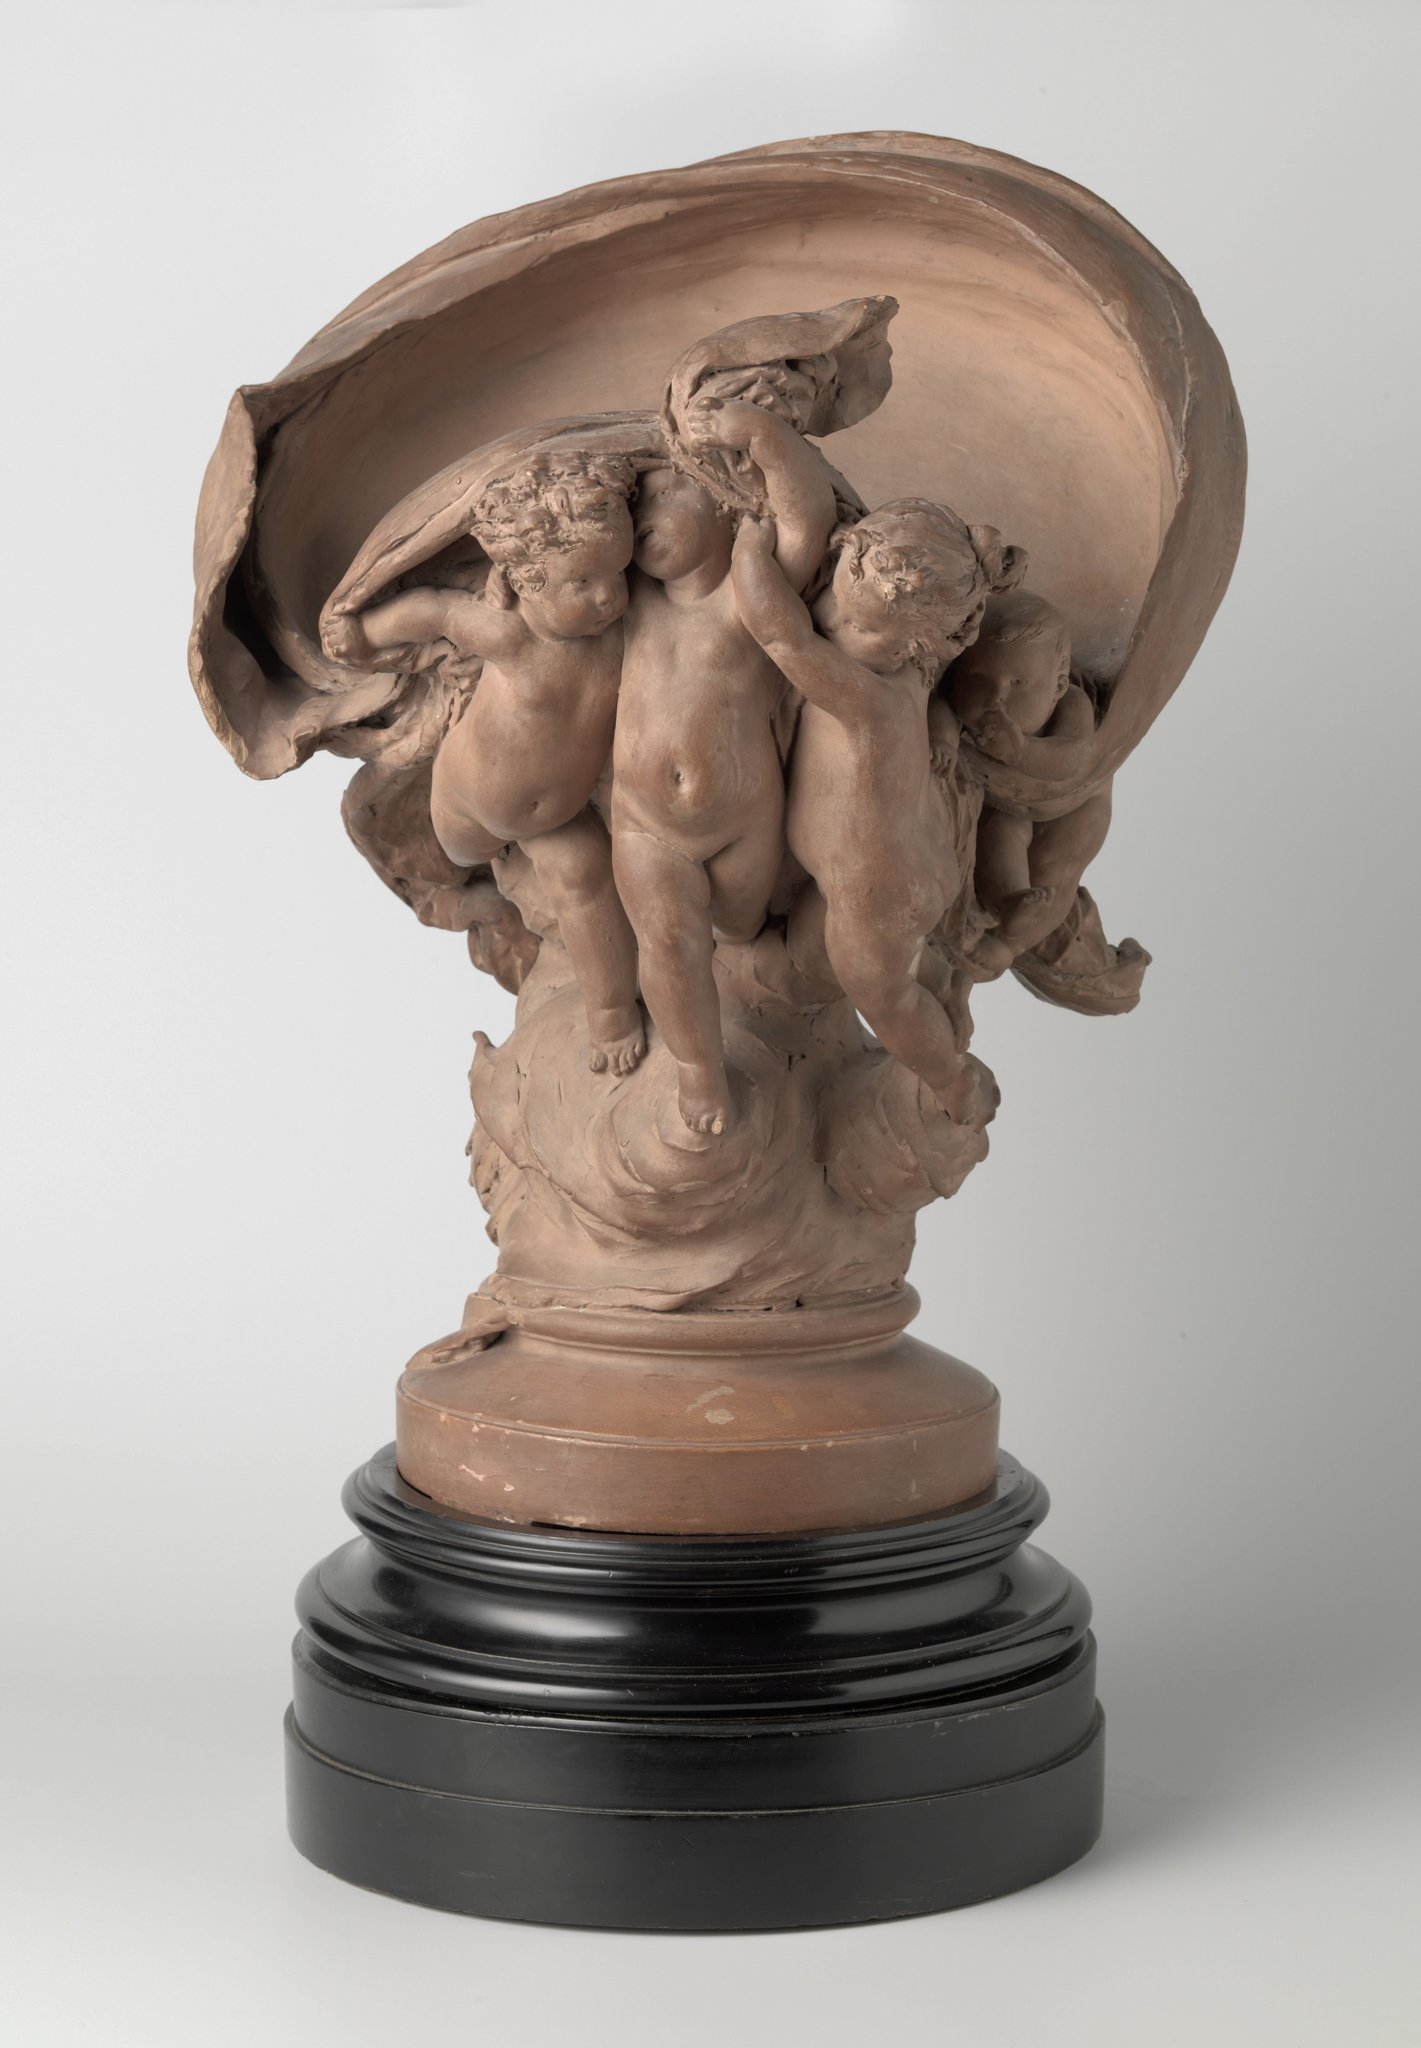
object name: table piece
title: Coup de Vent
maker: gustave joseph chéret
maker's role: sculptor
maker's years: 1838-1894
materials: terracotta, wood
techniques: molding, painting, pressing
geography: london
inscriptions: stamp: ‘J. Chéret’, : ‘Bellman & Ivey Manufacturers of Pedestals for Statuary &c. to the Queen 1851 Prize Medals 1862 95 Wigmore Str. W. London.’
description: Aan de voorzijde zweven op een rond voetstuk drie putti op een wolk, terwijl ze een sterk opbollend zeil of doek vasthouden, waarachter zich vier andere putti zwevend en tuimelend schuilen voor de sterke wind. Het doek fungeert als schaal. Gesigneerd met stempel: J. Chéret (op de zijkant boven de ronde voet). De bijgemaakte draaibare voet van hout is Engels en is gemerkt met een rond plaatje: Bellman & Ivey Manufacturers of Pedestals for Statuary &c. to the Queen 1851, Prize Medals 1862, 95 Wigmore Str. W. London.